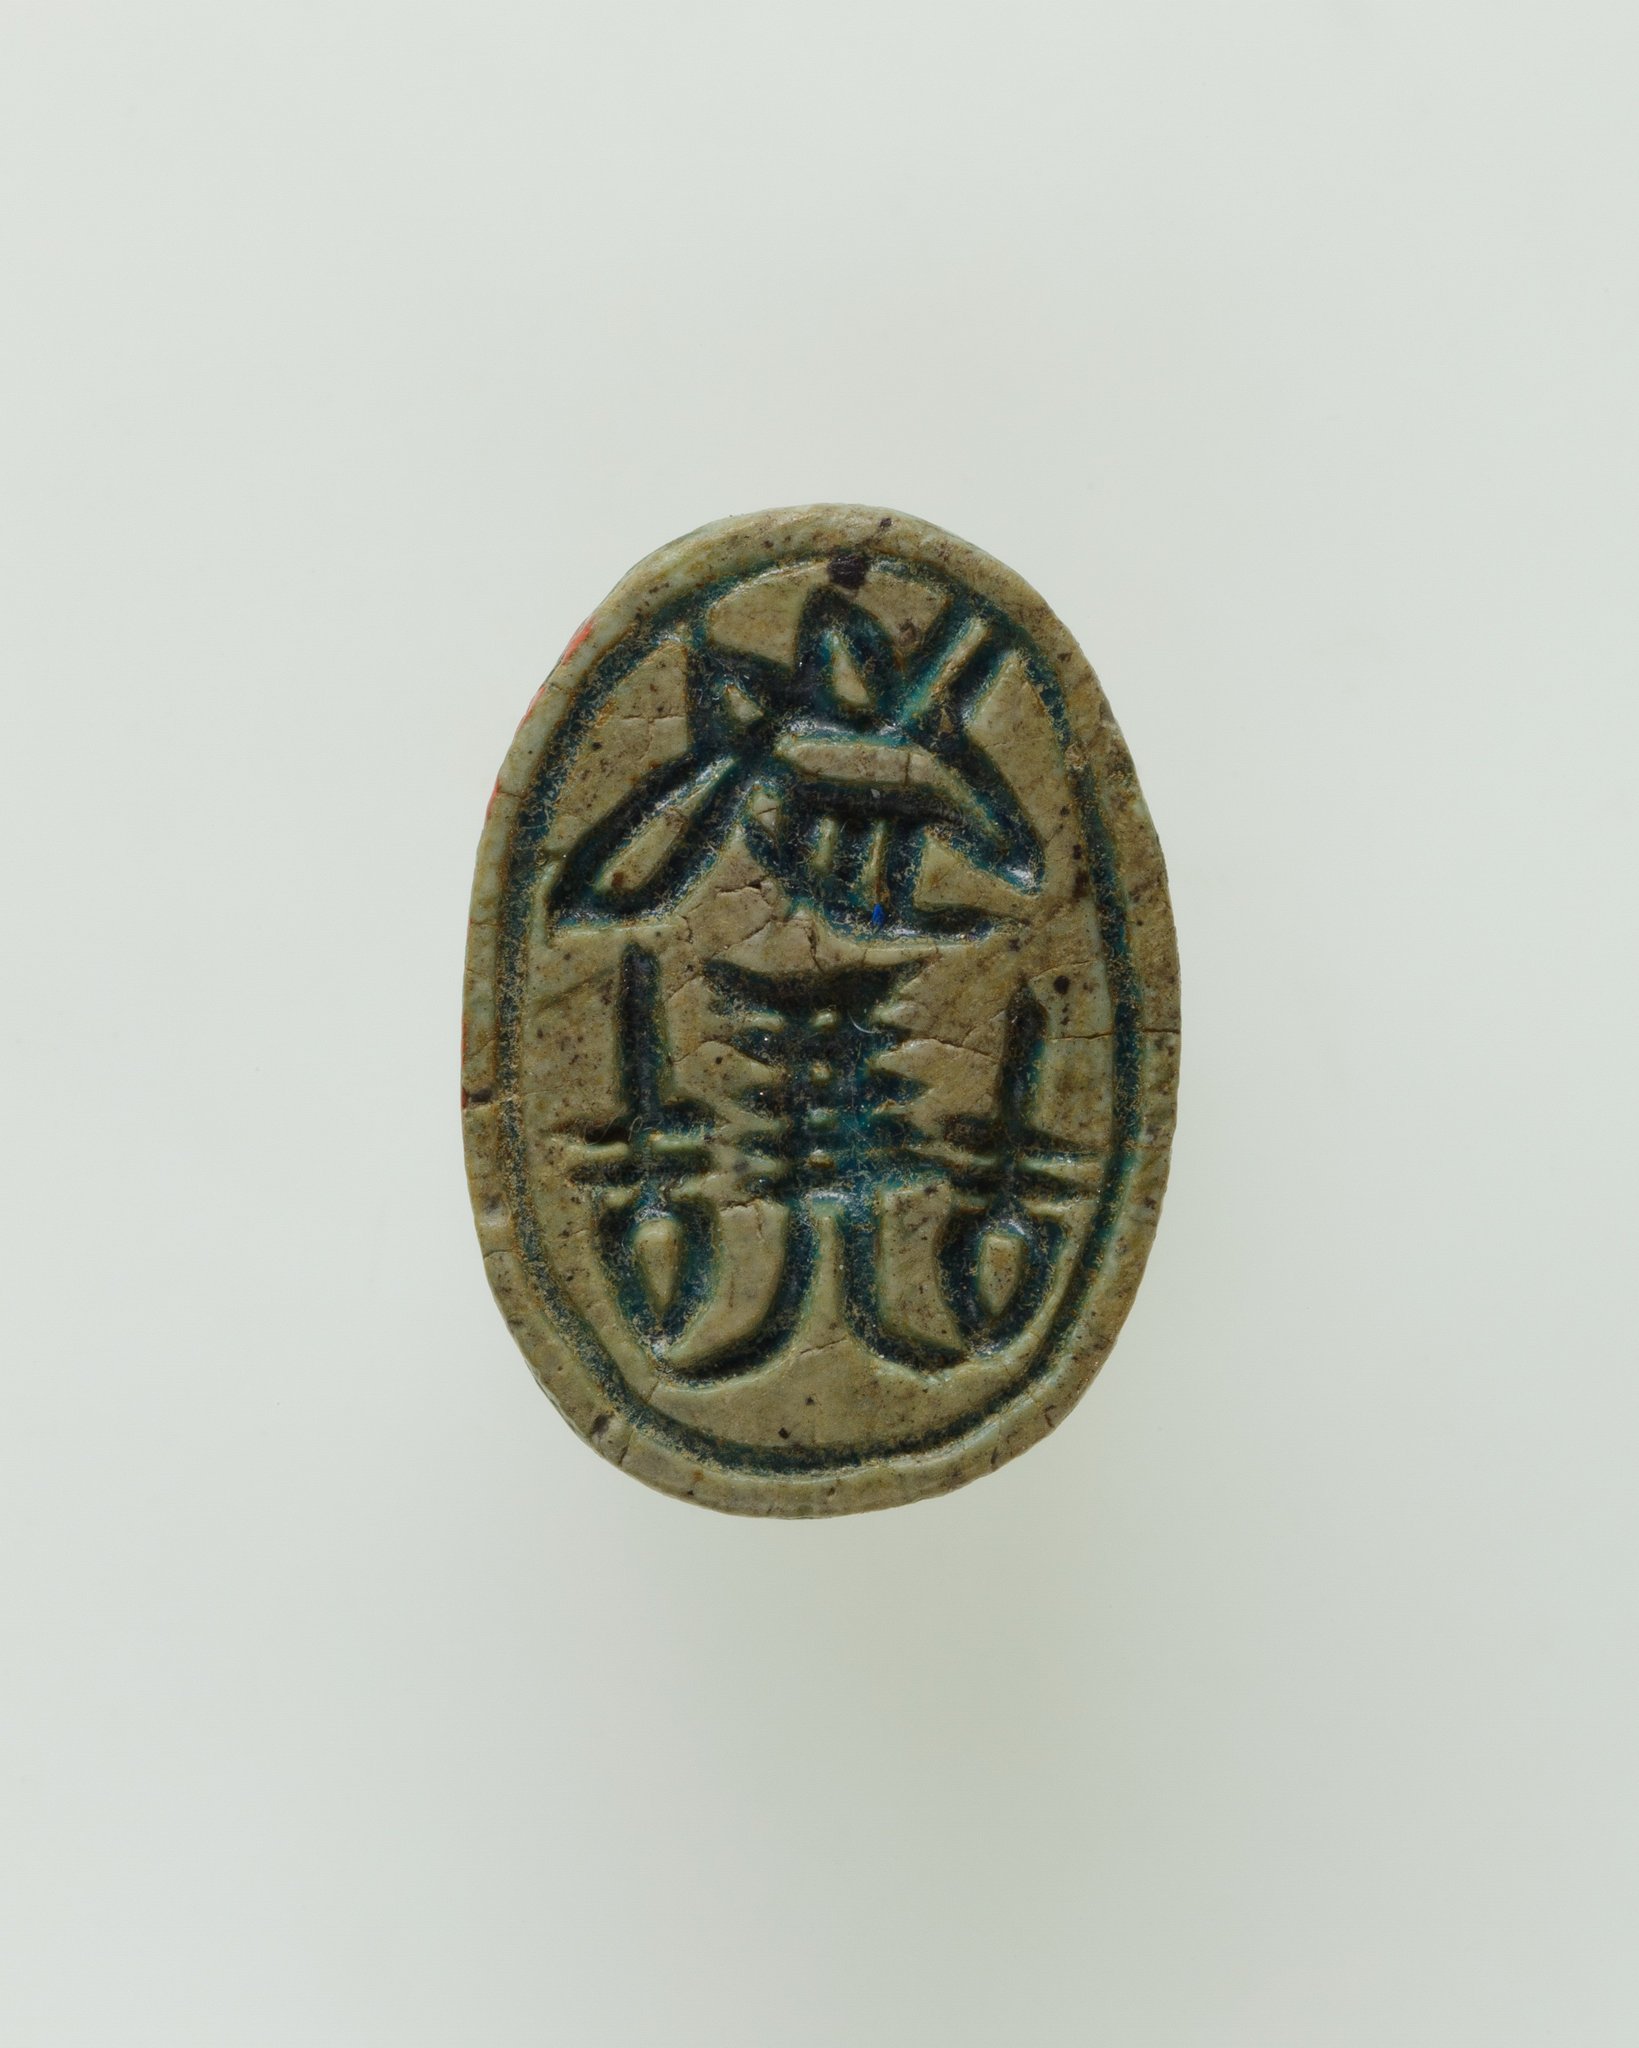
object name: scarab, bee, djed, ankh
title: Scarab with Hieroglyphs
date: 1850-1640 BCE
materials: stone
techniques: glazing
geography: egypt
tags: hieroglyphs,scarabs